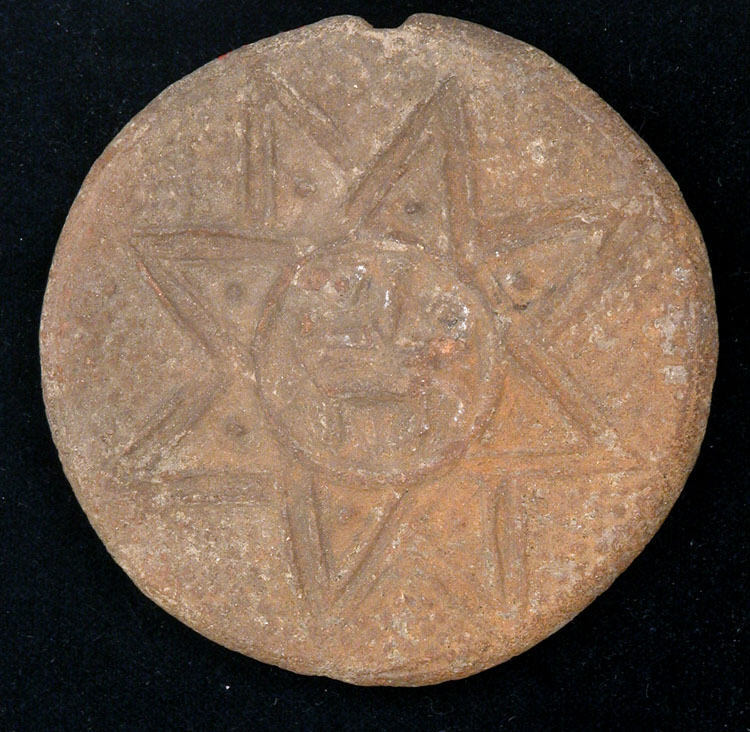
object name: bath scraper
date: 1101-1300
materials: earthenware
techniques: molding, relief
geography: iran